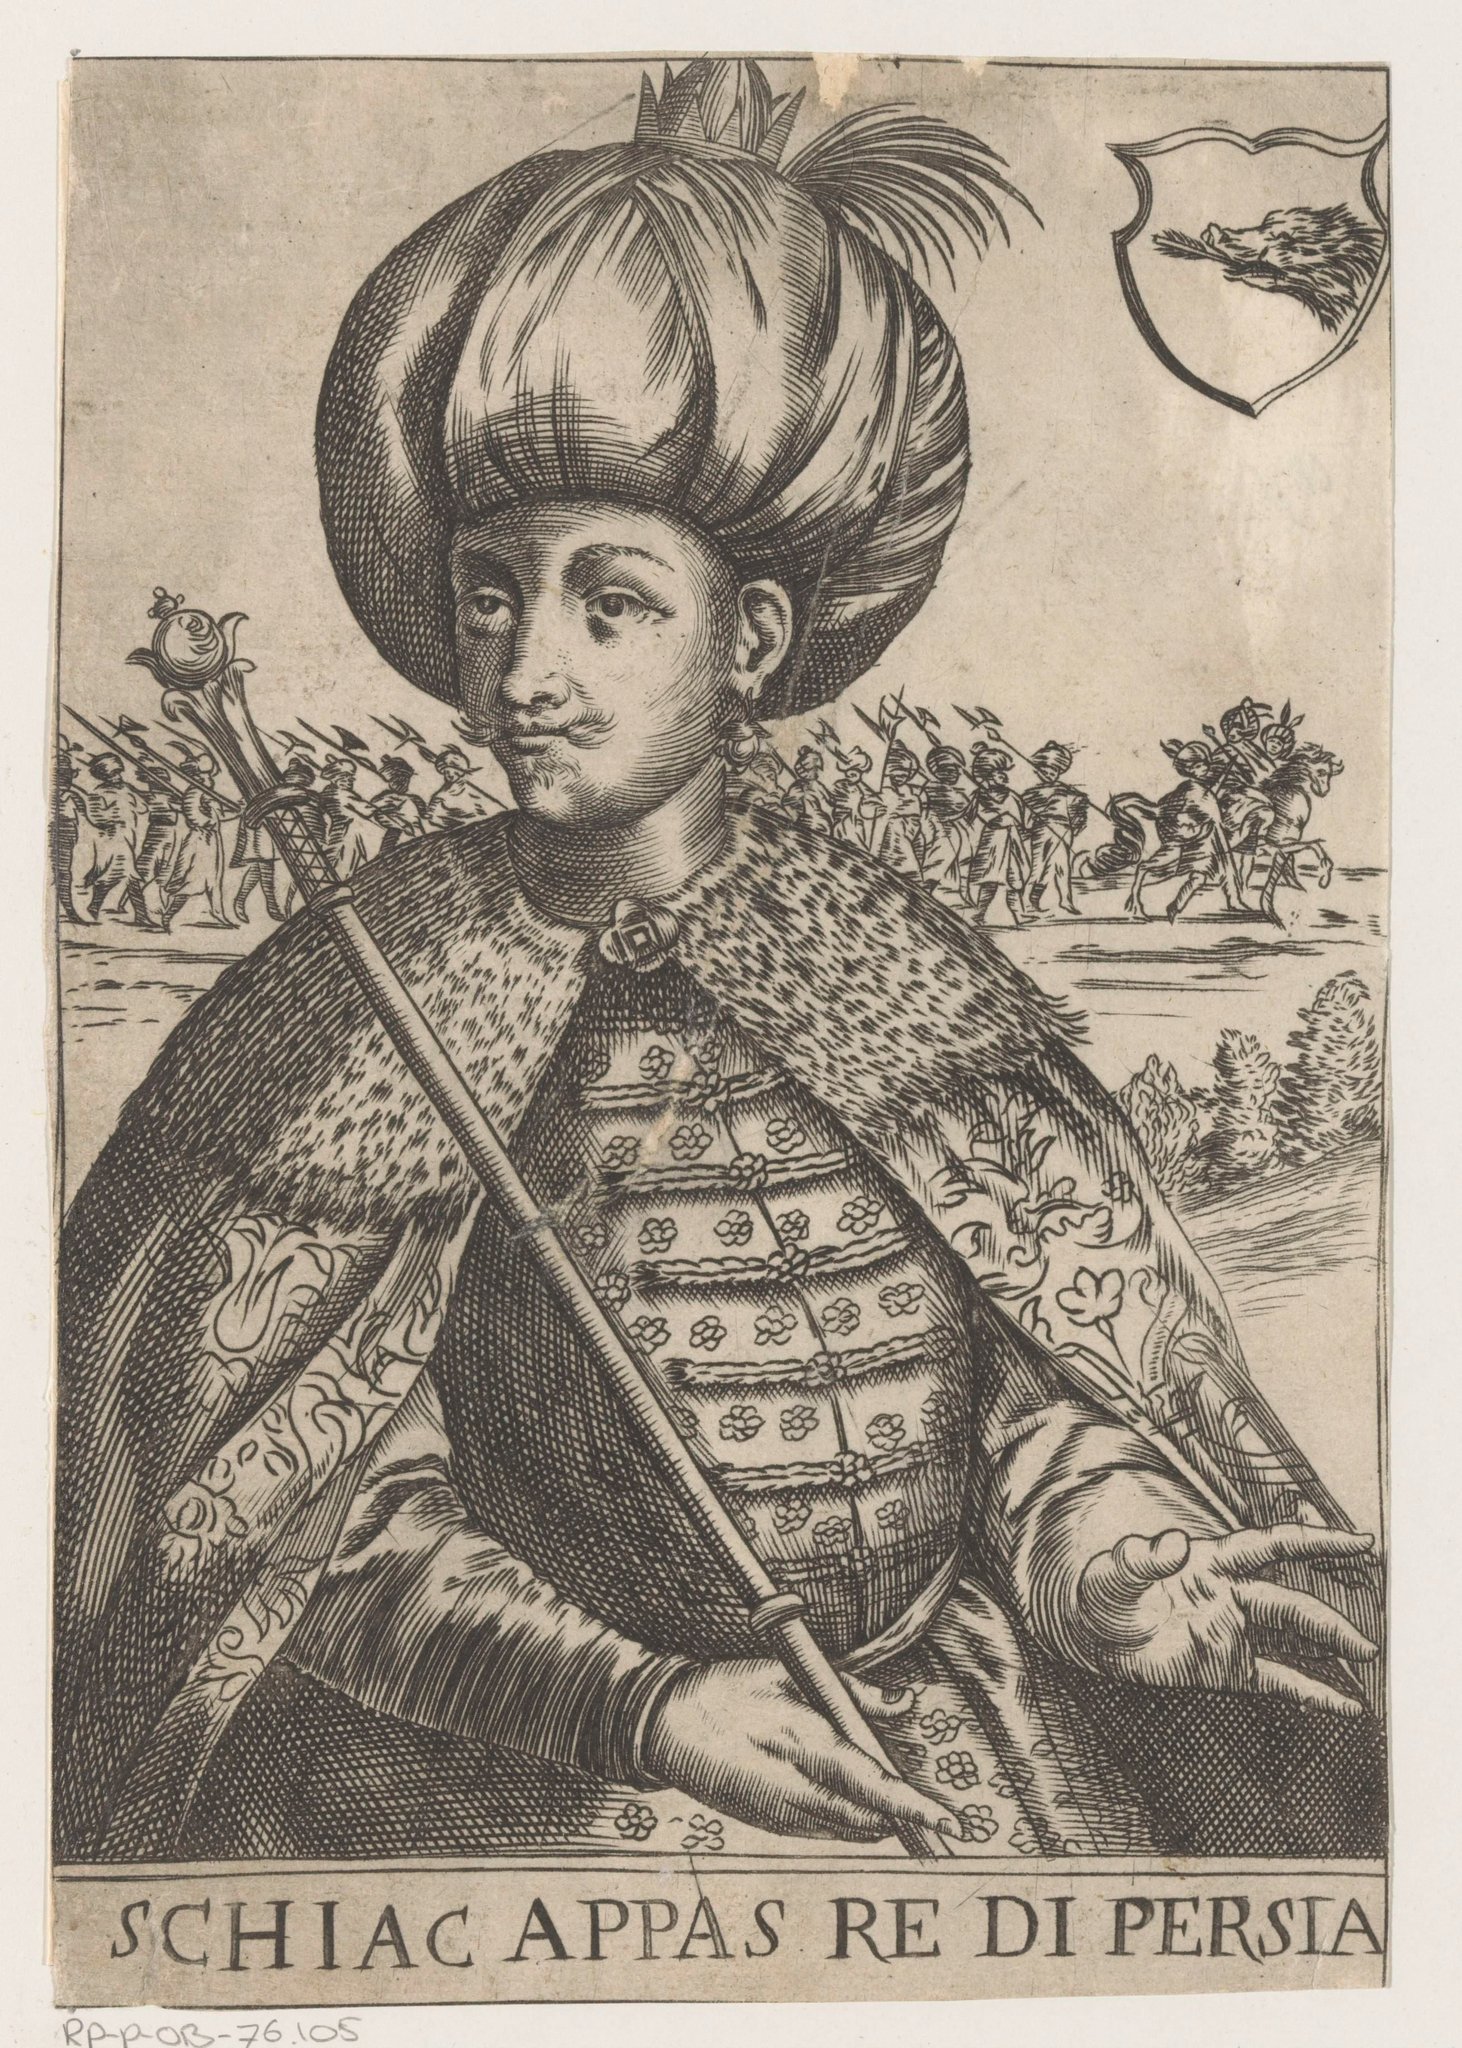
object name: print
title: Portret van Abbas I, sjah van Perzië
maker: Anonymous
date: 1600-1699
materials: paper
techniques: engraving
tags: coat of arms (symbol of sovereignty), sceptre, staff (symbol of sovereignty), head-gear: turban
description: Portret van Abbas I in een rechthoekige omlijsting. Hij draagt een tulband en heeft een scepter in zijn rechterhand. Op de achtergrond trekt een leger voorbij. Rechtsboven een wapen. In de ondermarge zijn naam en titel.